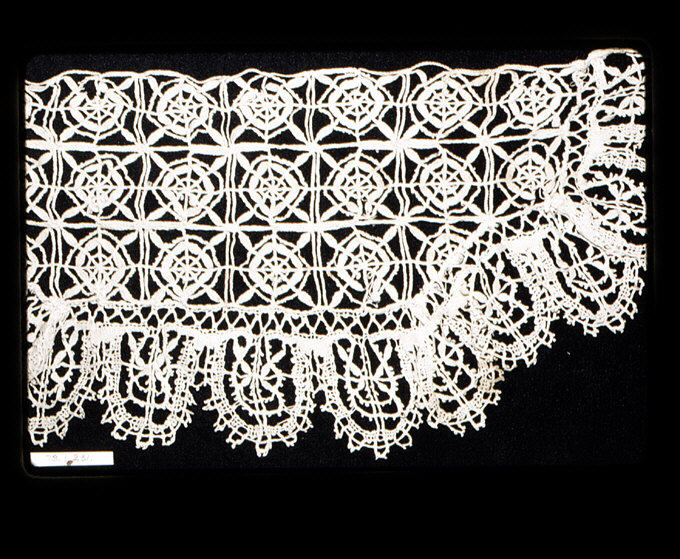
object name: fragment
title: Fragment of lace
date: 1601-1700